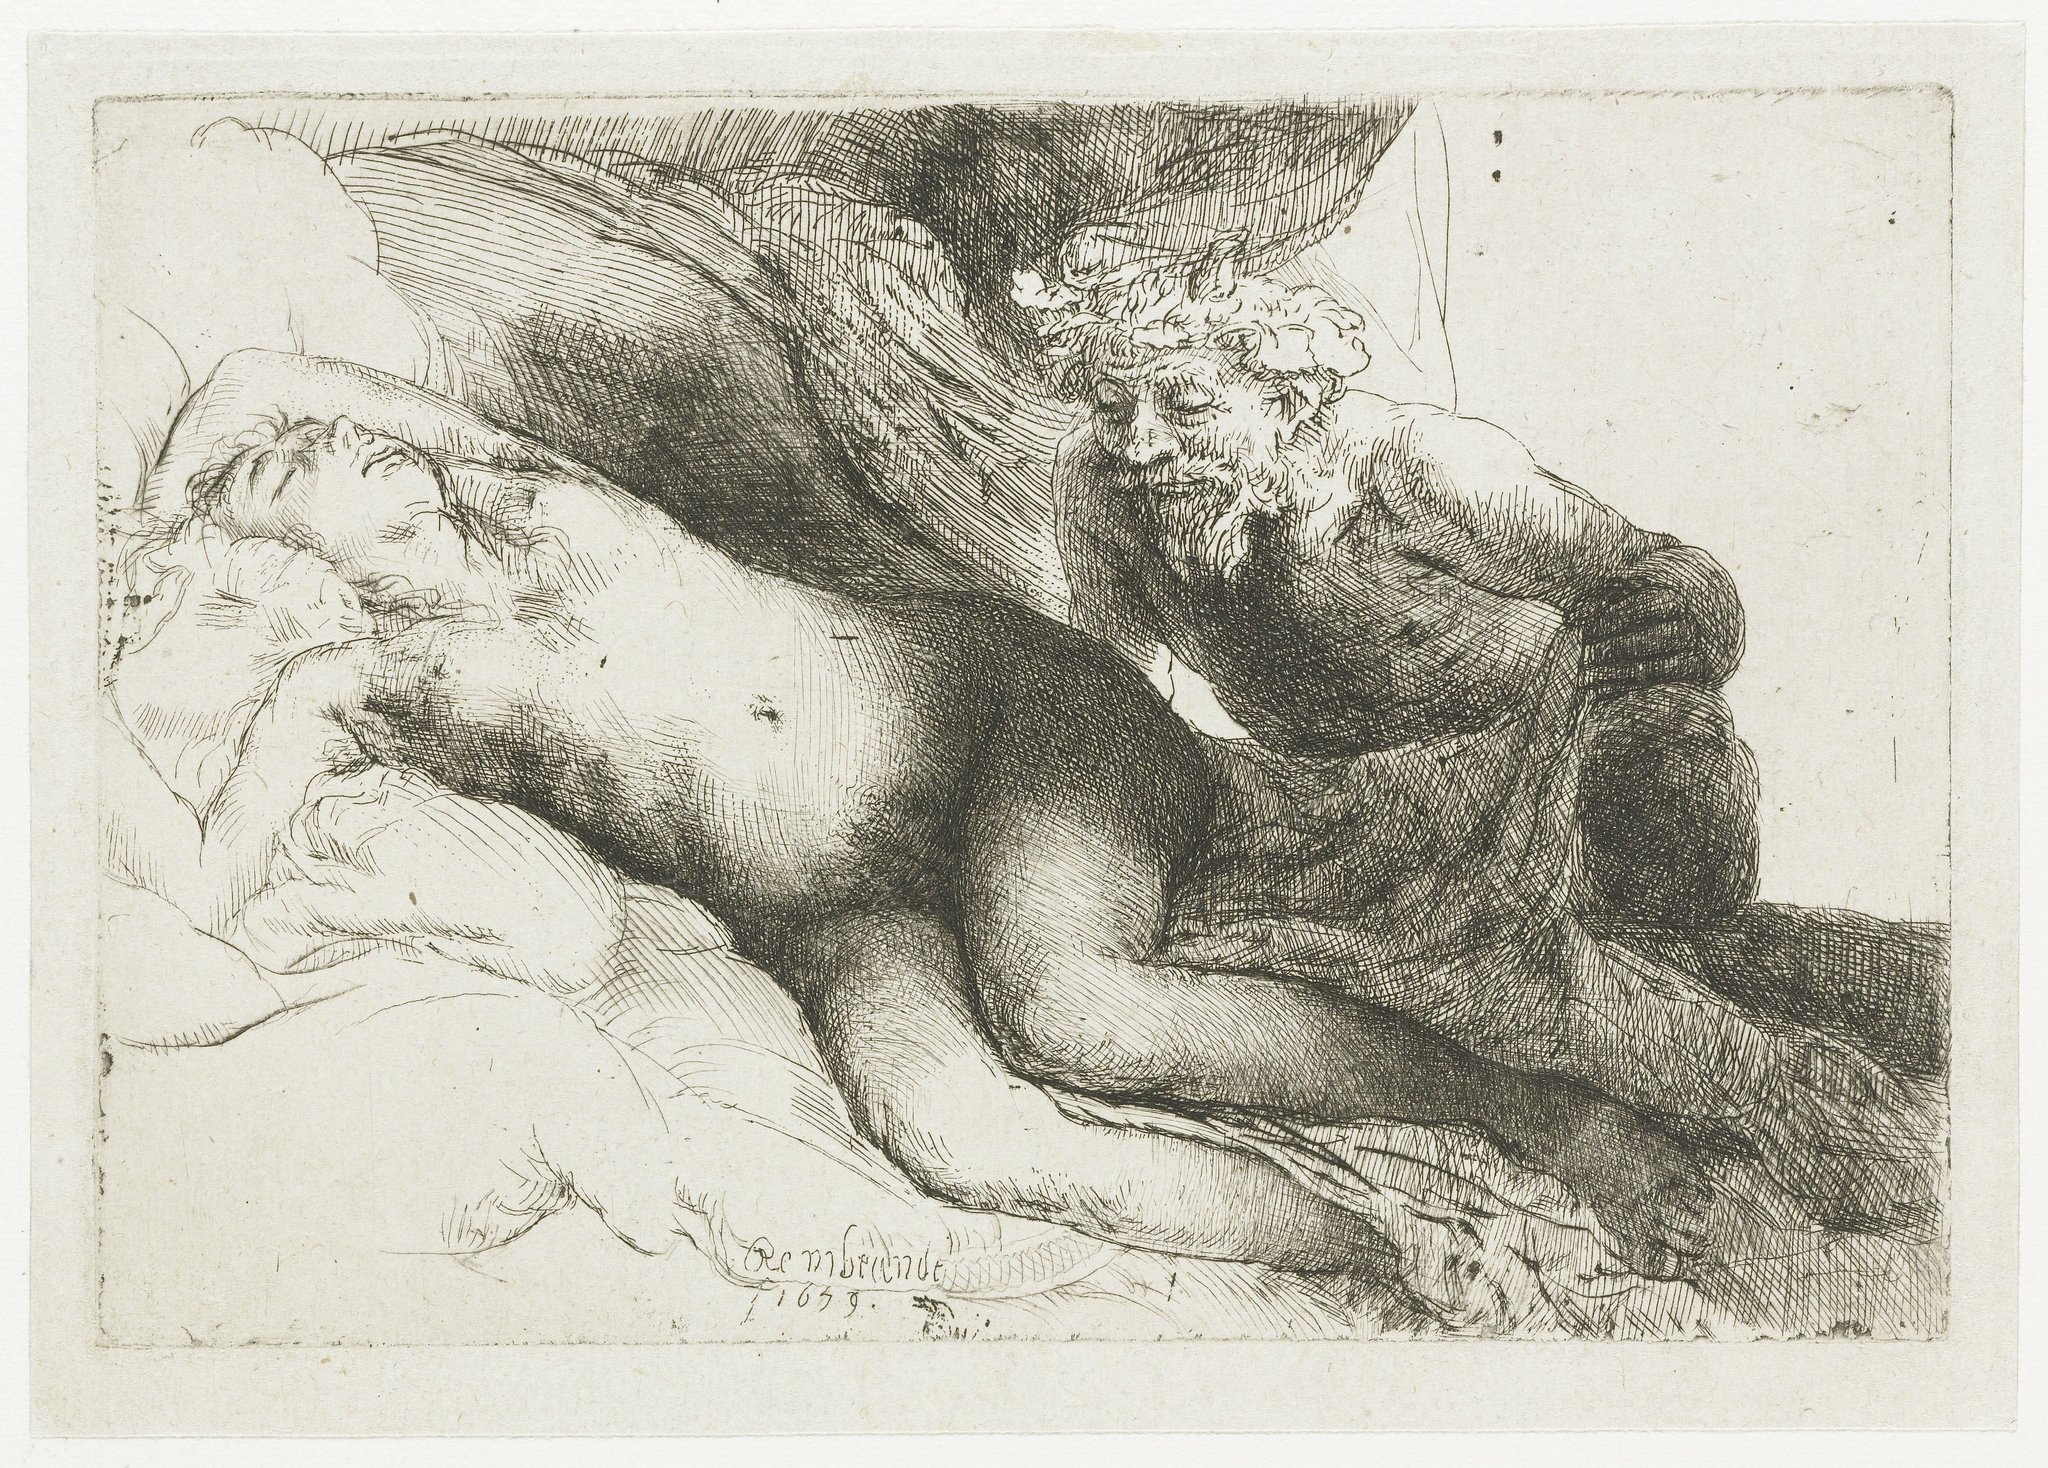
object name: print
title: Jupiter and Antiope: the larger plate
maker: rembrandt van rijn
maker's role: draughtsman, painter, print maker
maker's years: 1606-1669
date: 1659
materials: paper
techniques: drypoint, etching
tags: jupiter, disguised as a satyr, approaches the sleeping antiope; the eagle may be standing nearby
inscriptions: signature and date: ‘Rembrandt f 1659’